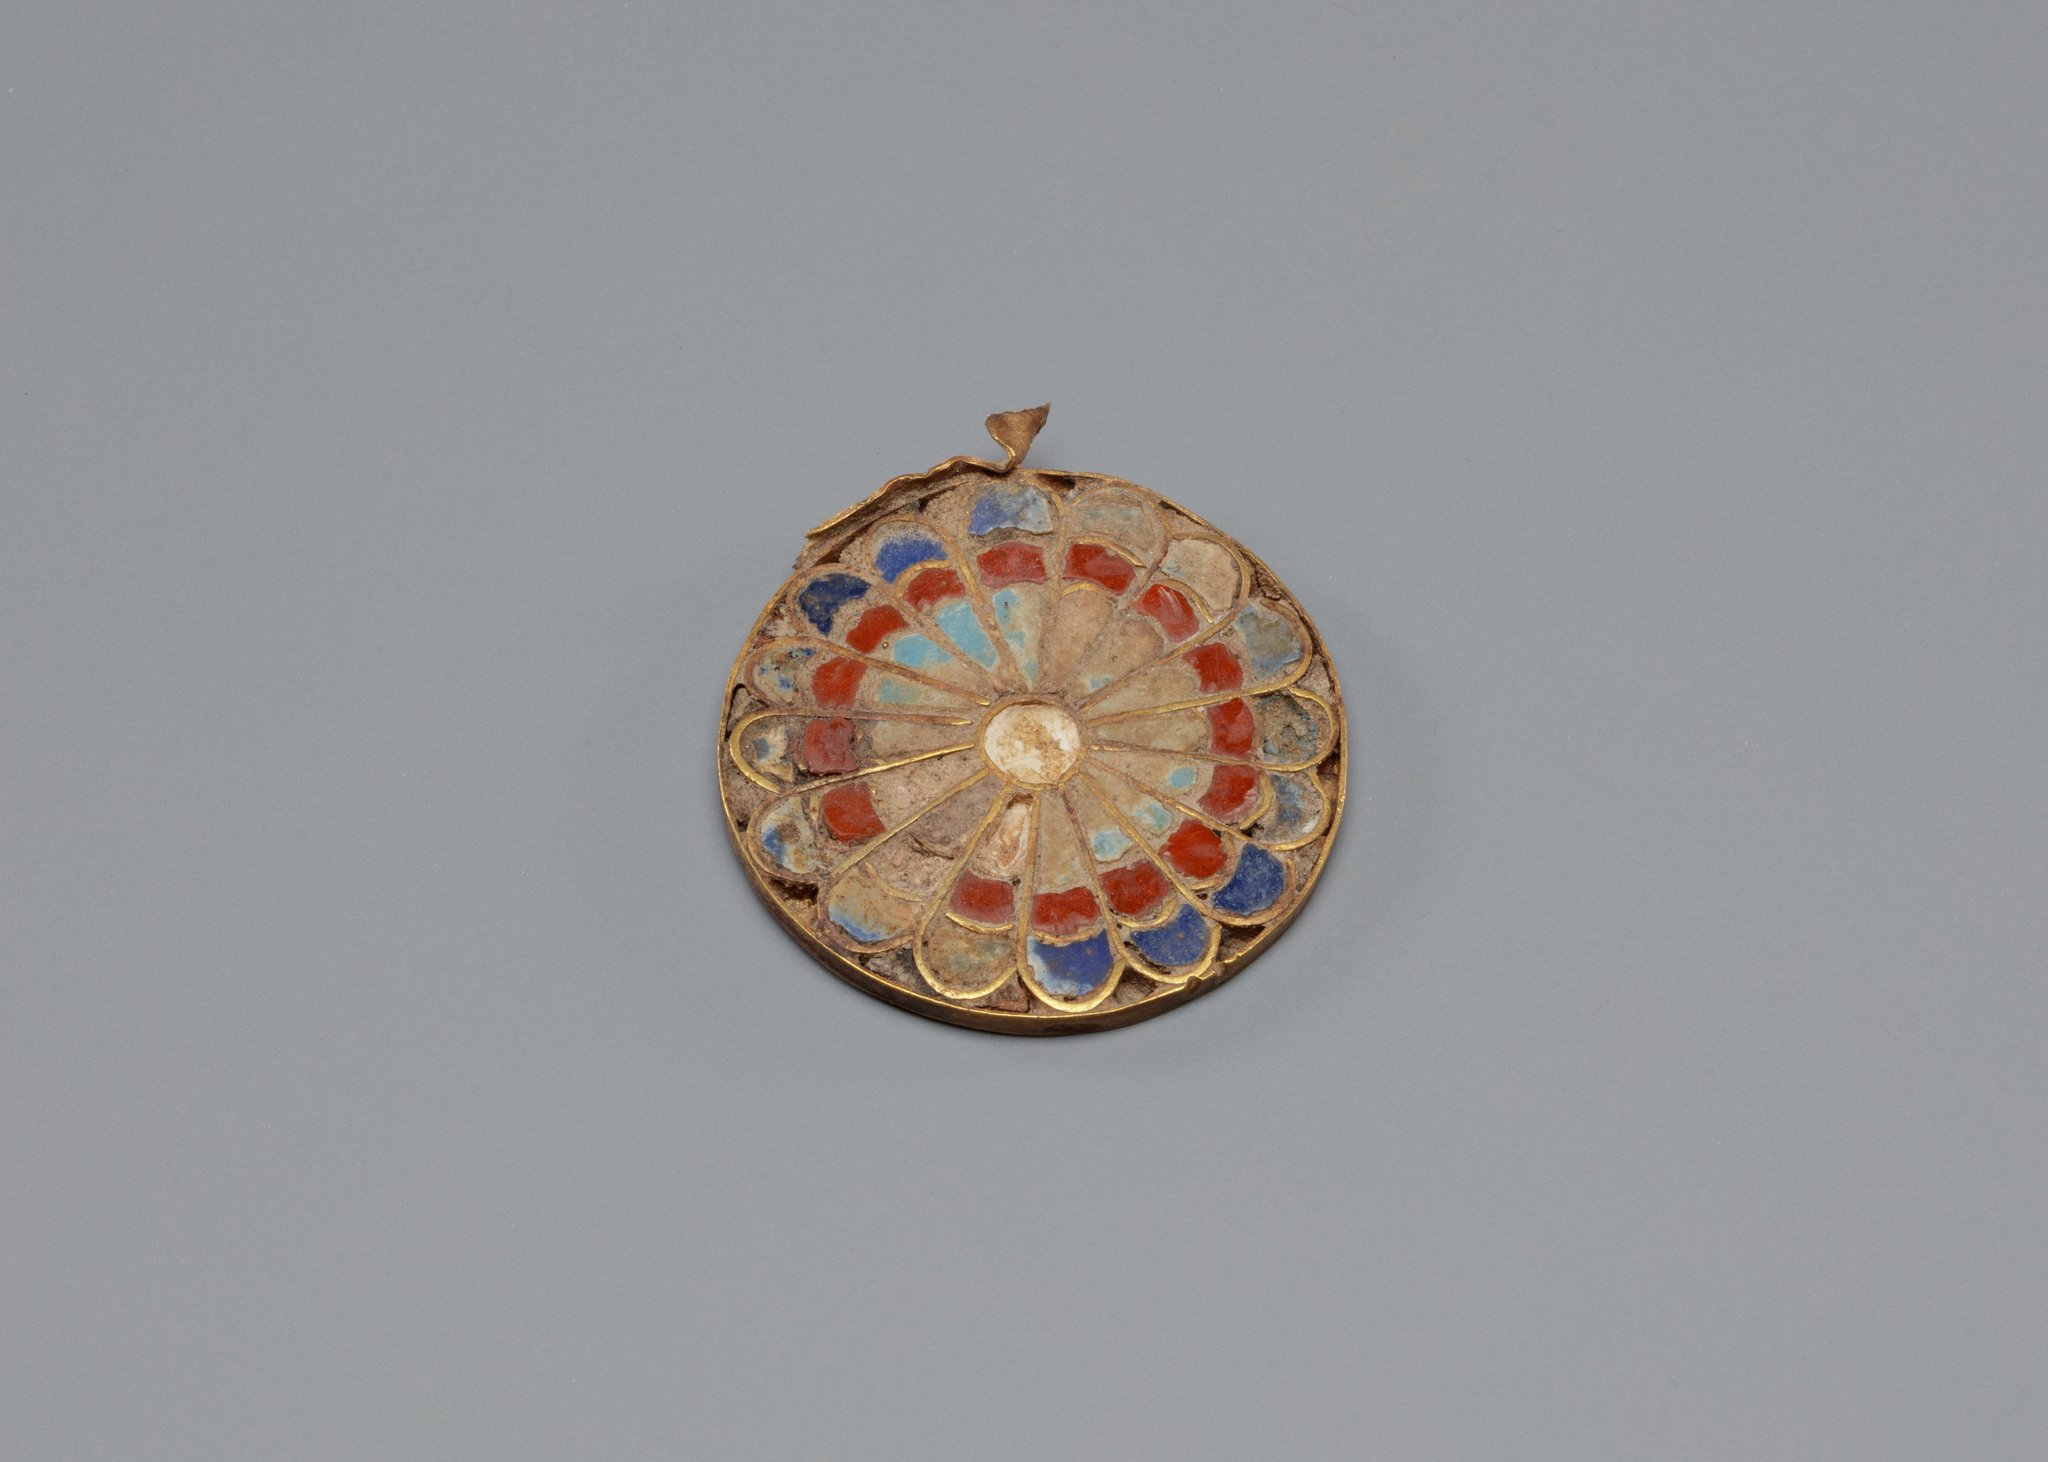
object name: rosette, inlaid, kv 42, senetnay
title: Inlaid Rosette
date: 1427-1400 BCE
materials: faience, glass, gold, jasper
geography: egypt